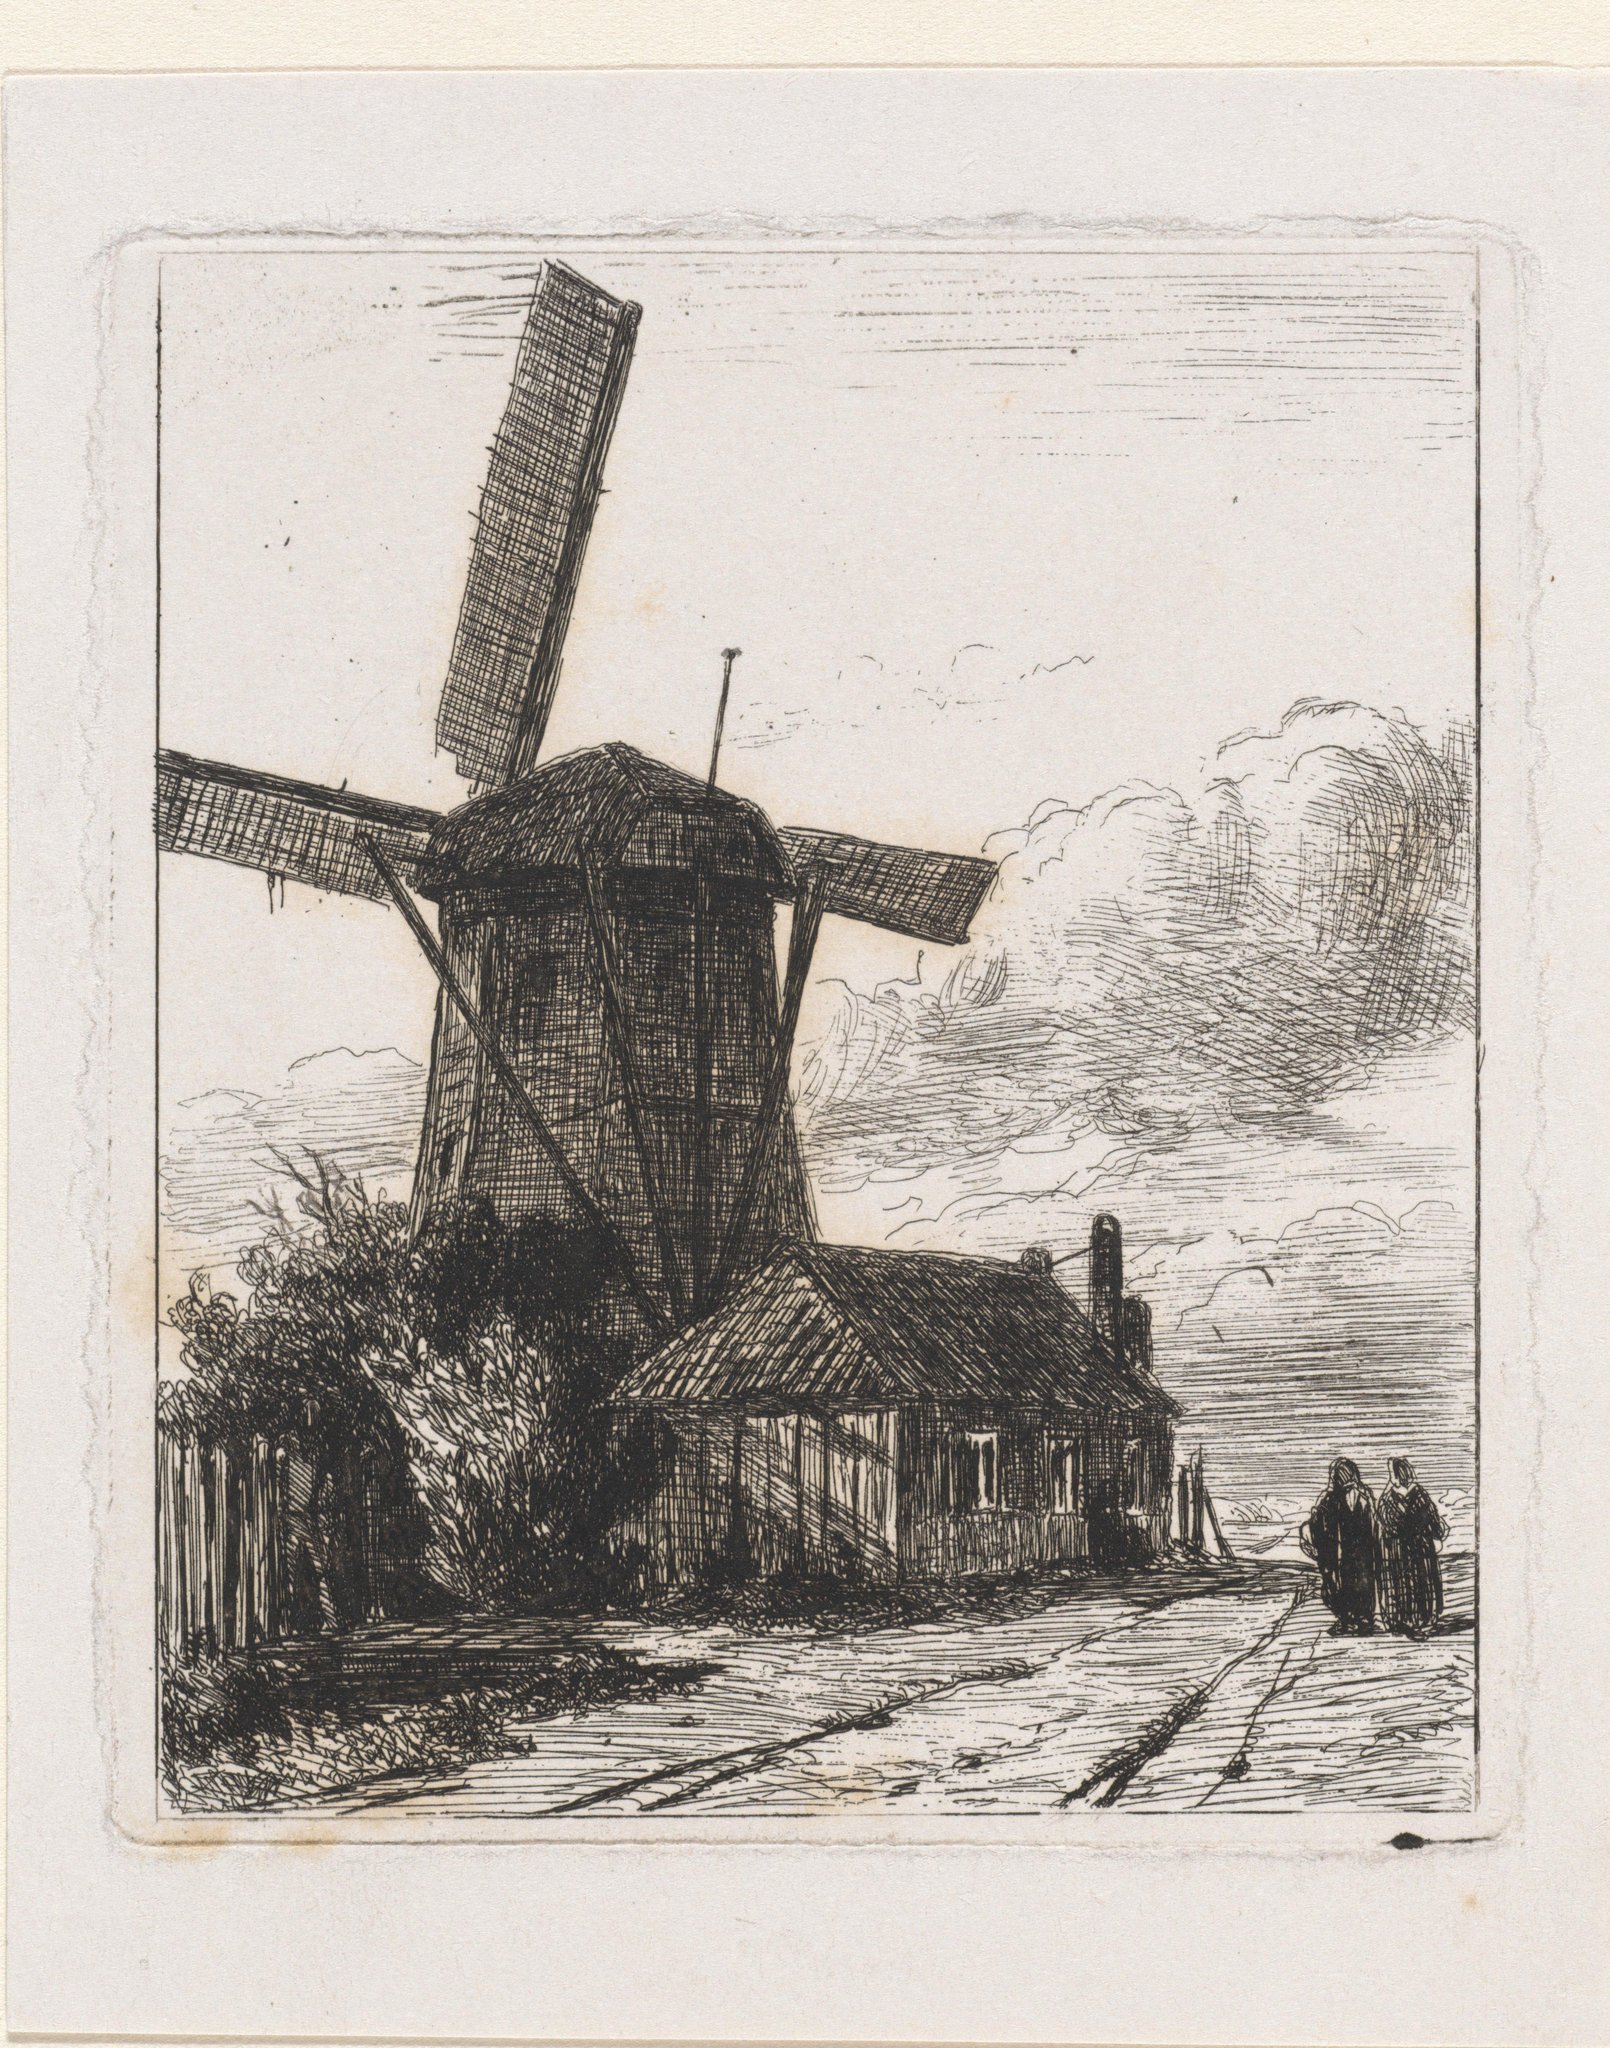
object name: print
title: Gezicht op de Trekweg te Den Haag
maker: jan weissenbruch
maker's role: painter, print maker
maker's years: 1822-1880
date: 1849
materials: paper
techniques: etching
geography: the hague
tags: fence, wall, paling, rural housing, e.g. country-house, villa, cottage, road, path, windmill in landscape, walking, windmill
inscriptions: collector's mark: Lugt 2760, collector's mark: Lugt 2228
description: Over de Trekweg lopen enkele figuren. Links is een molen achter een huis weergegeven.